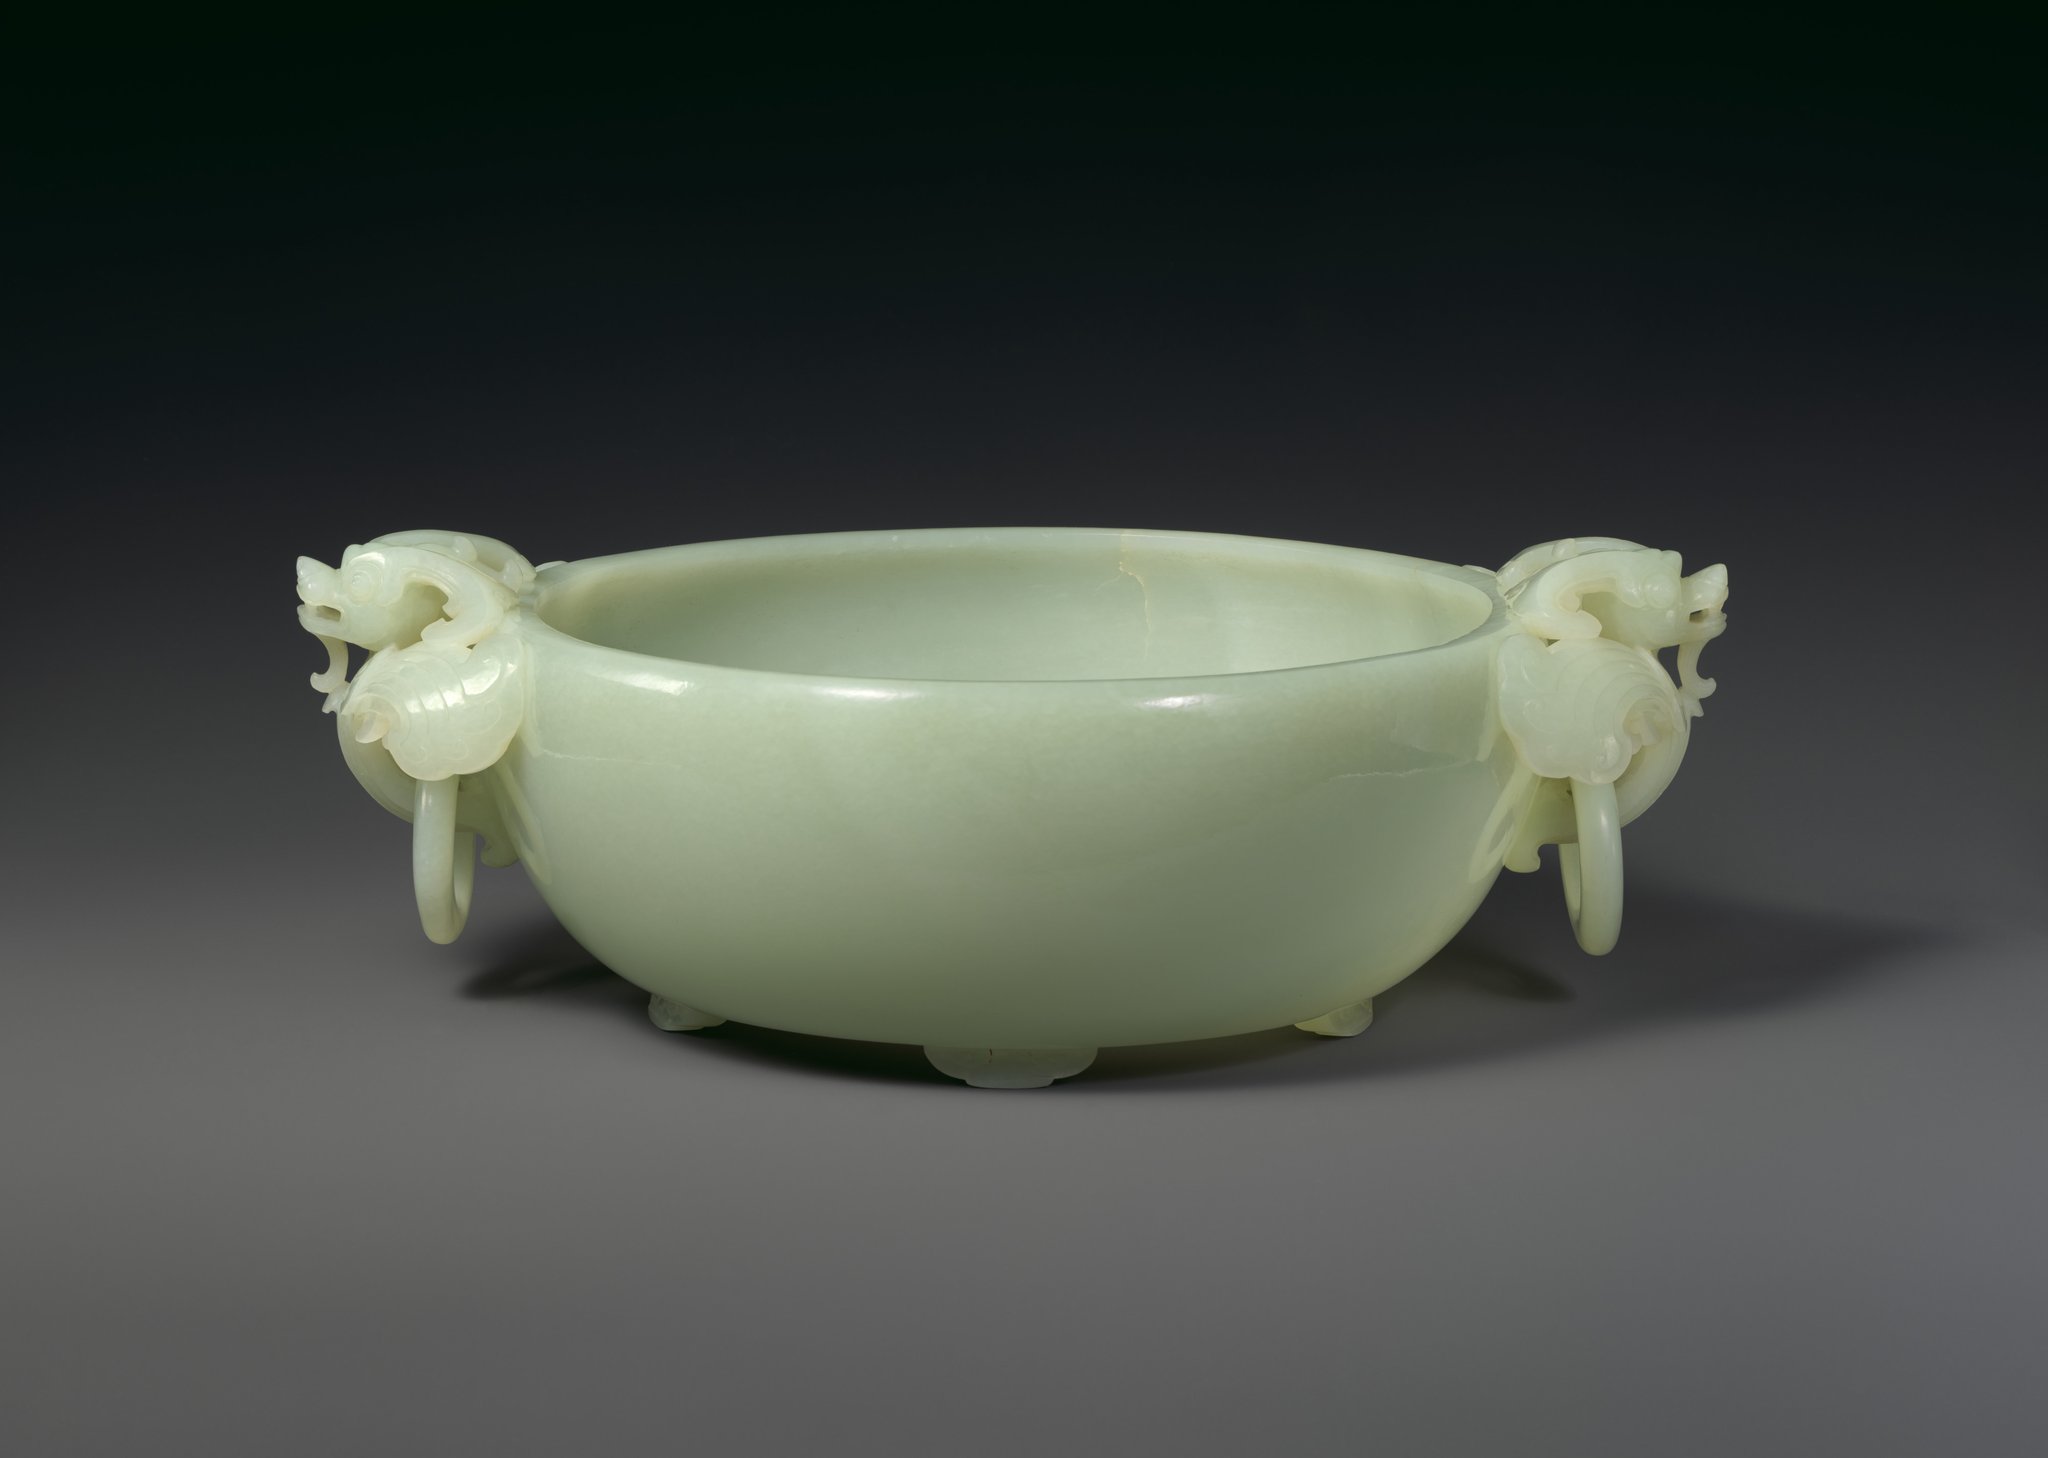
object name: bowl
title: Bowl with Two Dragon Handles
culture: chinese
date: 1644-1911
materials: jade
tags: dragons